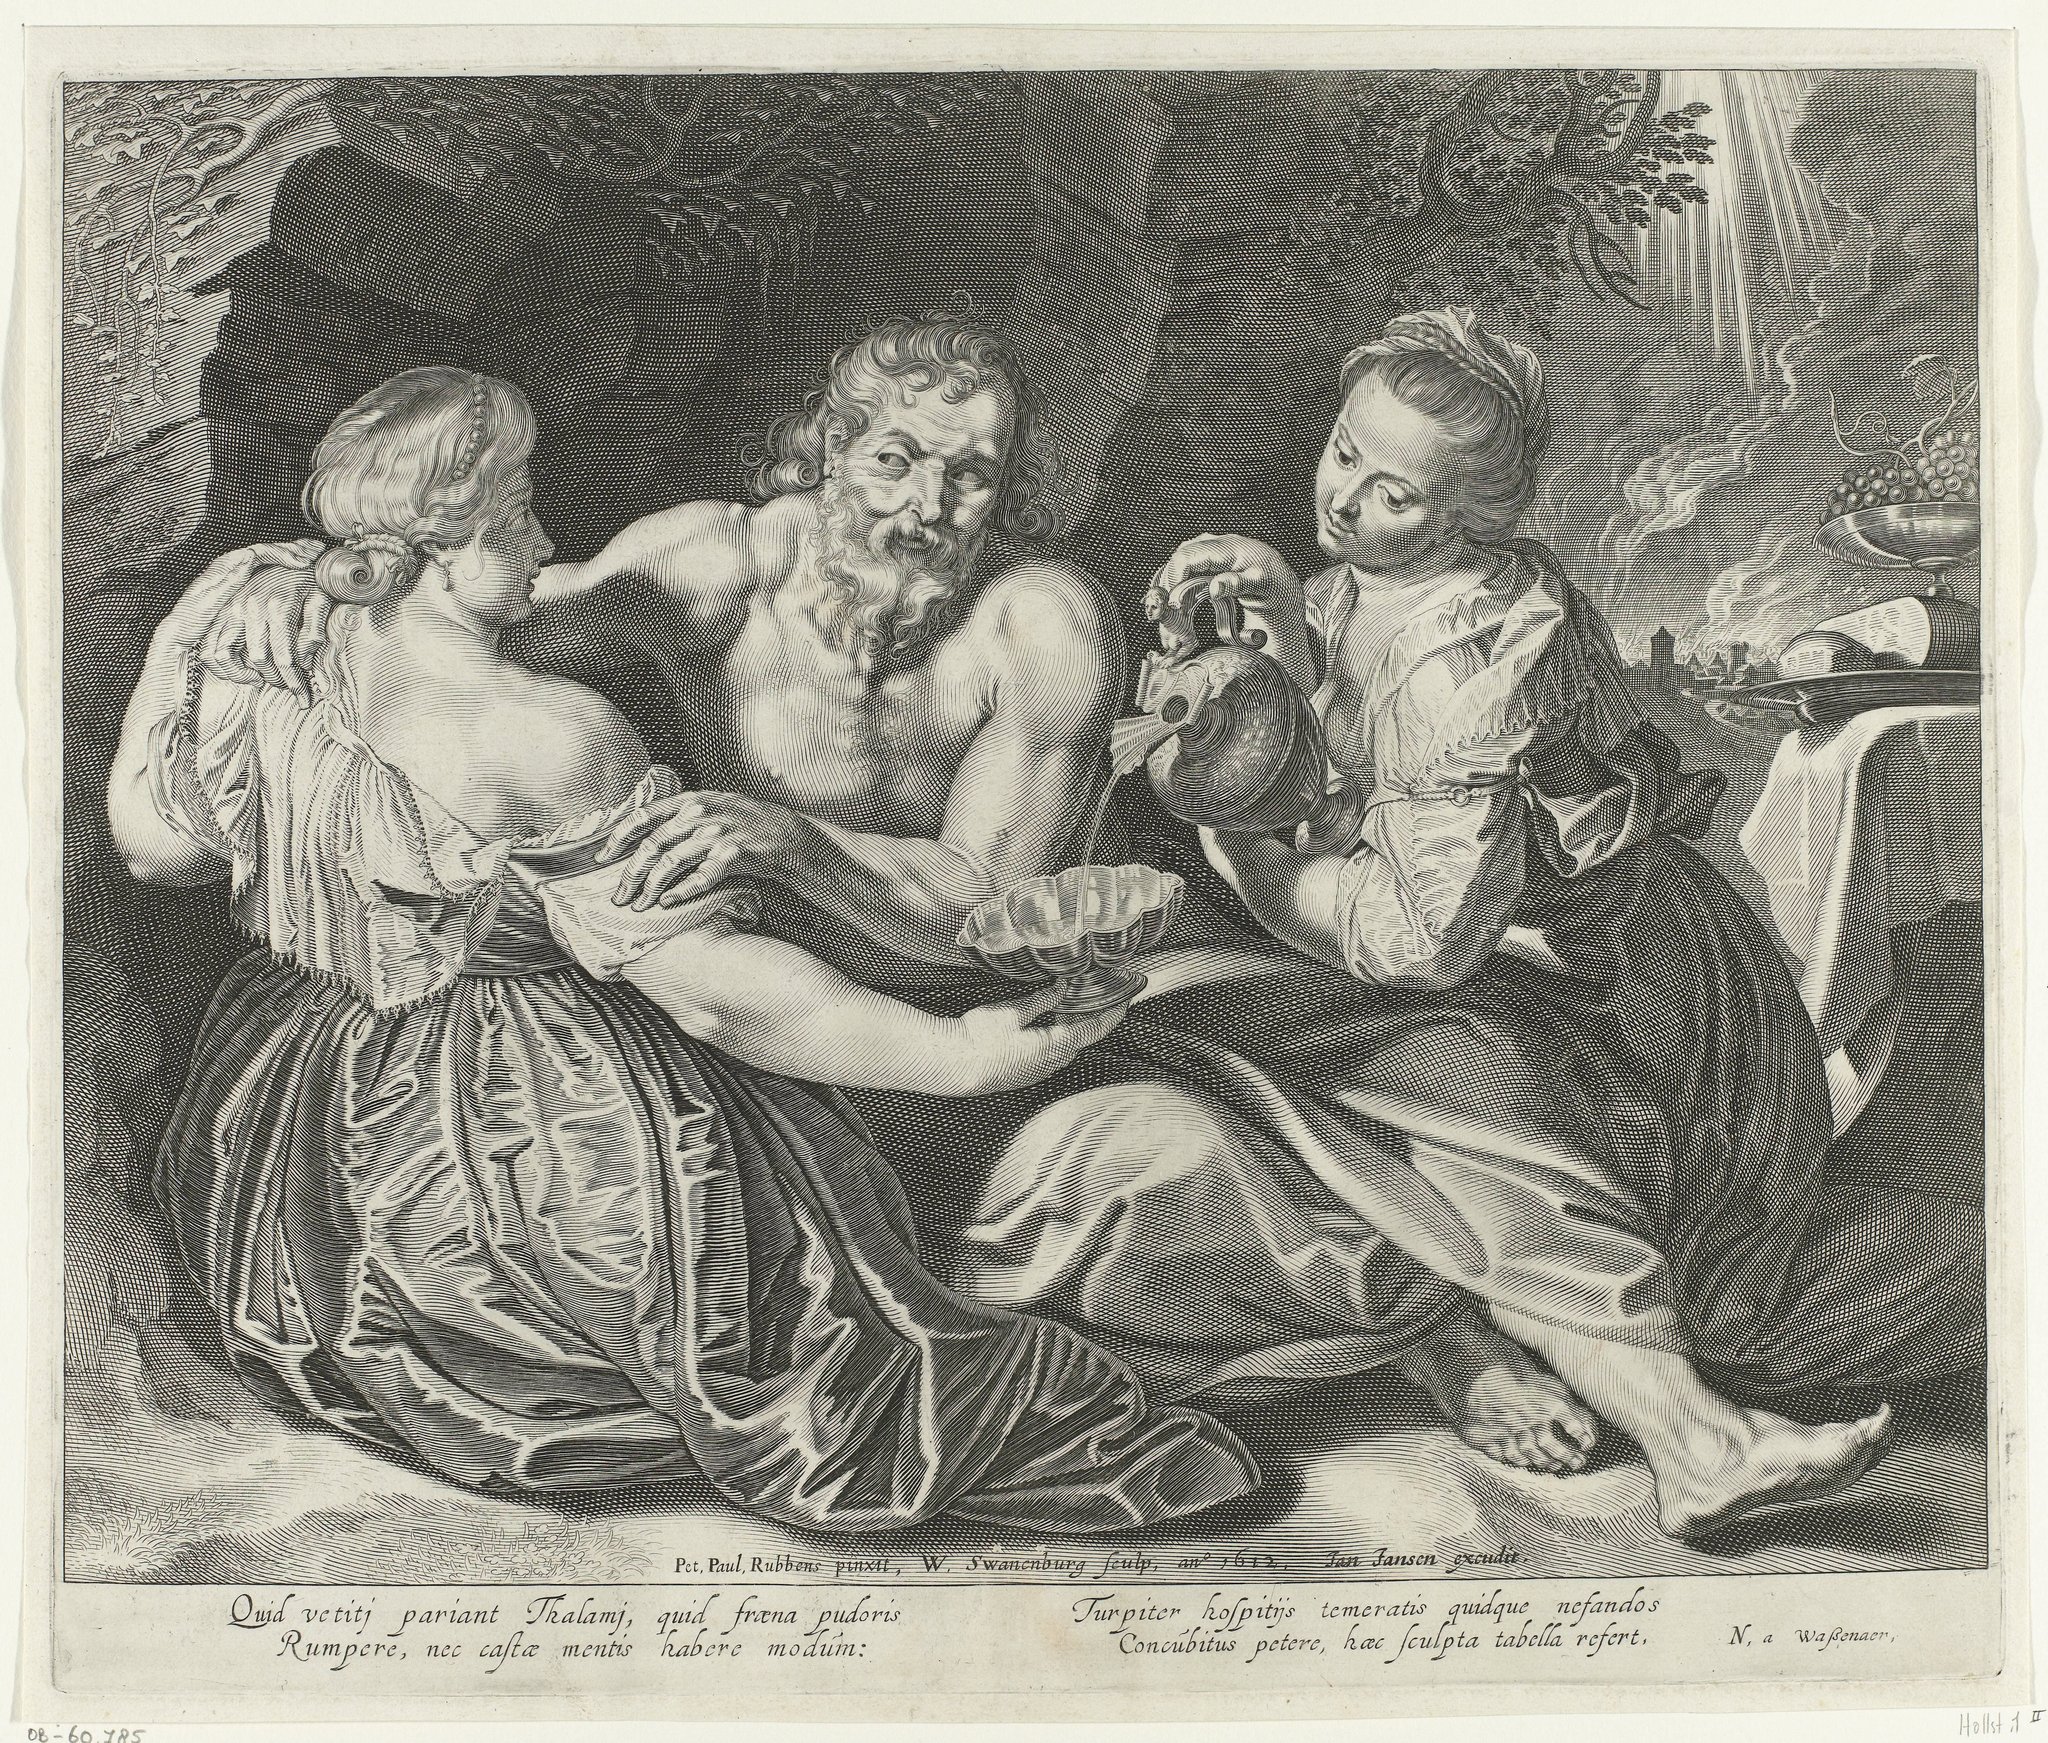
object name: print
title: Lot dronken gevoerd door zijn dochters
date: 1612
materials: paper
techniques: engraving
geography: leiden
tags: lot's daughters make their father drunk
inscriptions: collector's mark: Lugt 2228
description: Lot zit tussen zijn twee dochters voor een grot. De linkerdochter wordt door hem omhelsd. Ze houdt een bokaal vast, die door de andere dochter met wijn wordt gevuld. Rechts in de verte brandt Sodom. Onder de voorstelling bevindt zich een vierregelige, Latijnse tekst waarin de afgebeelde gebeurtenis afkeurend wordt besproken.